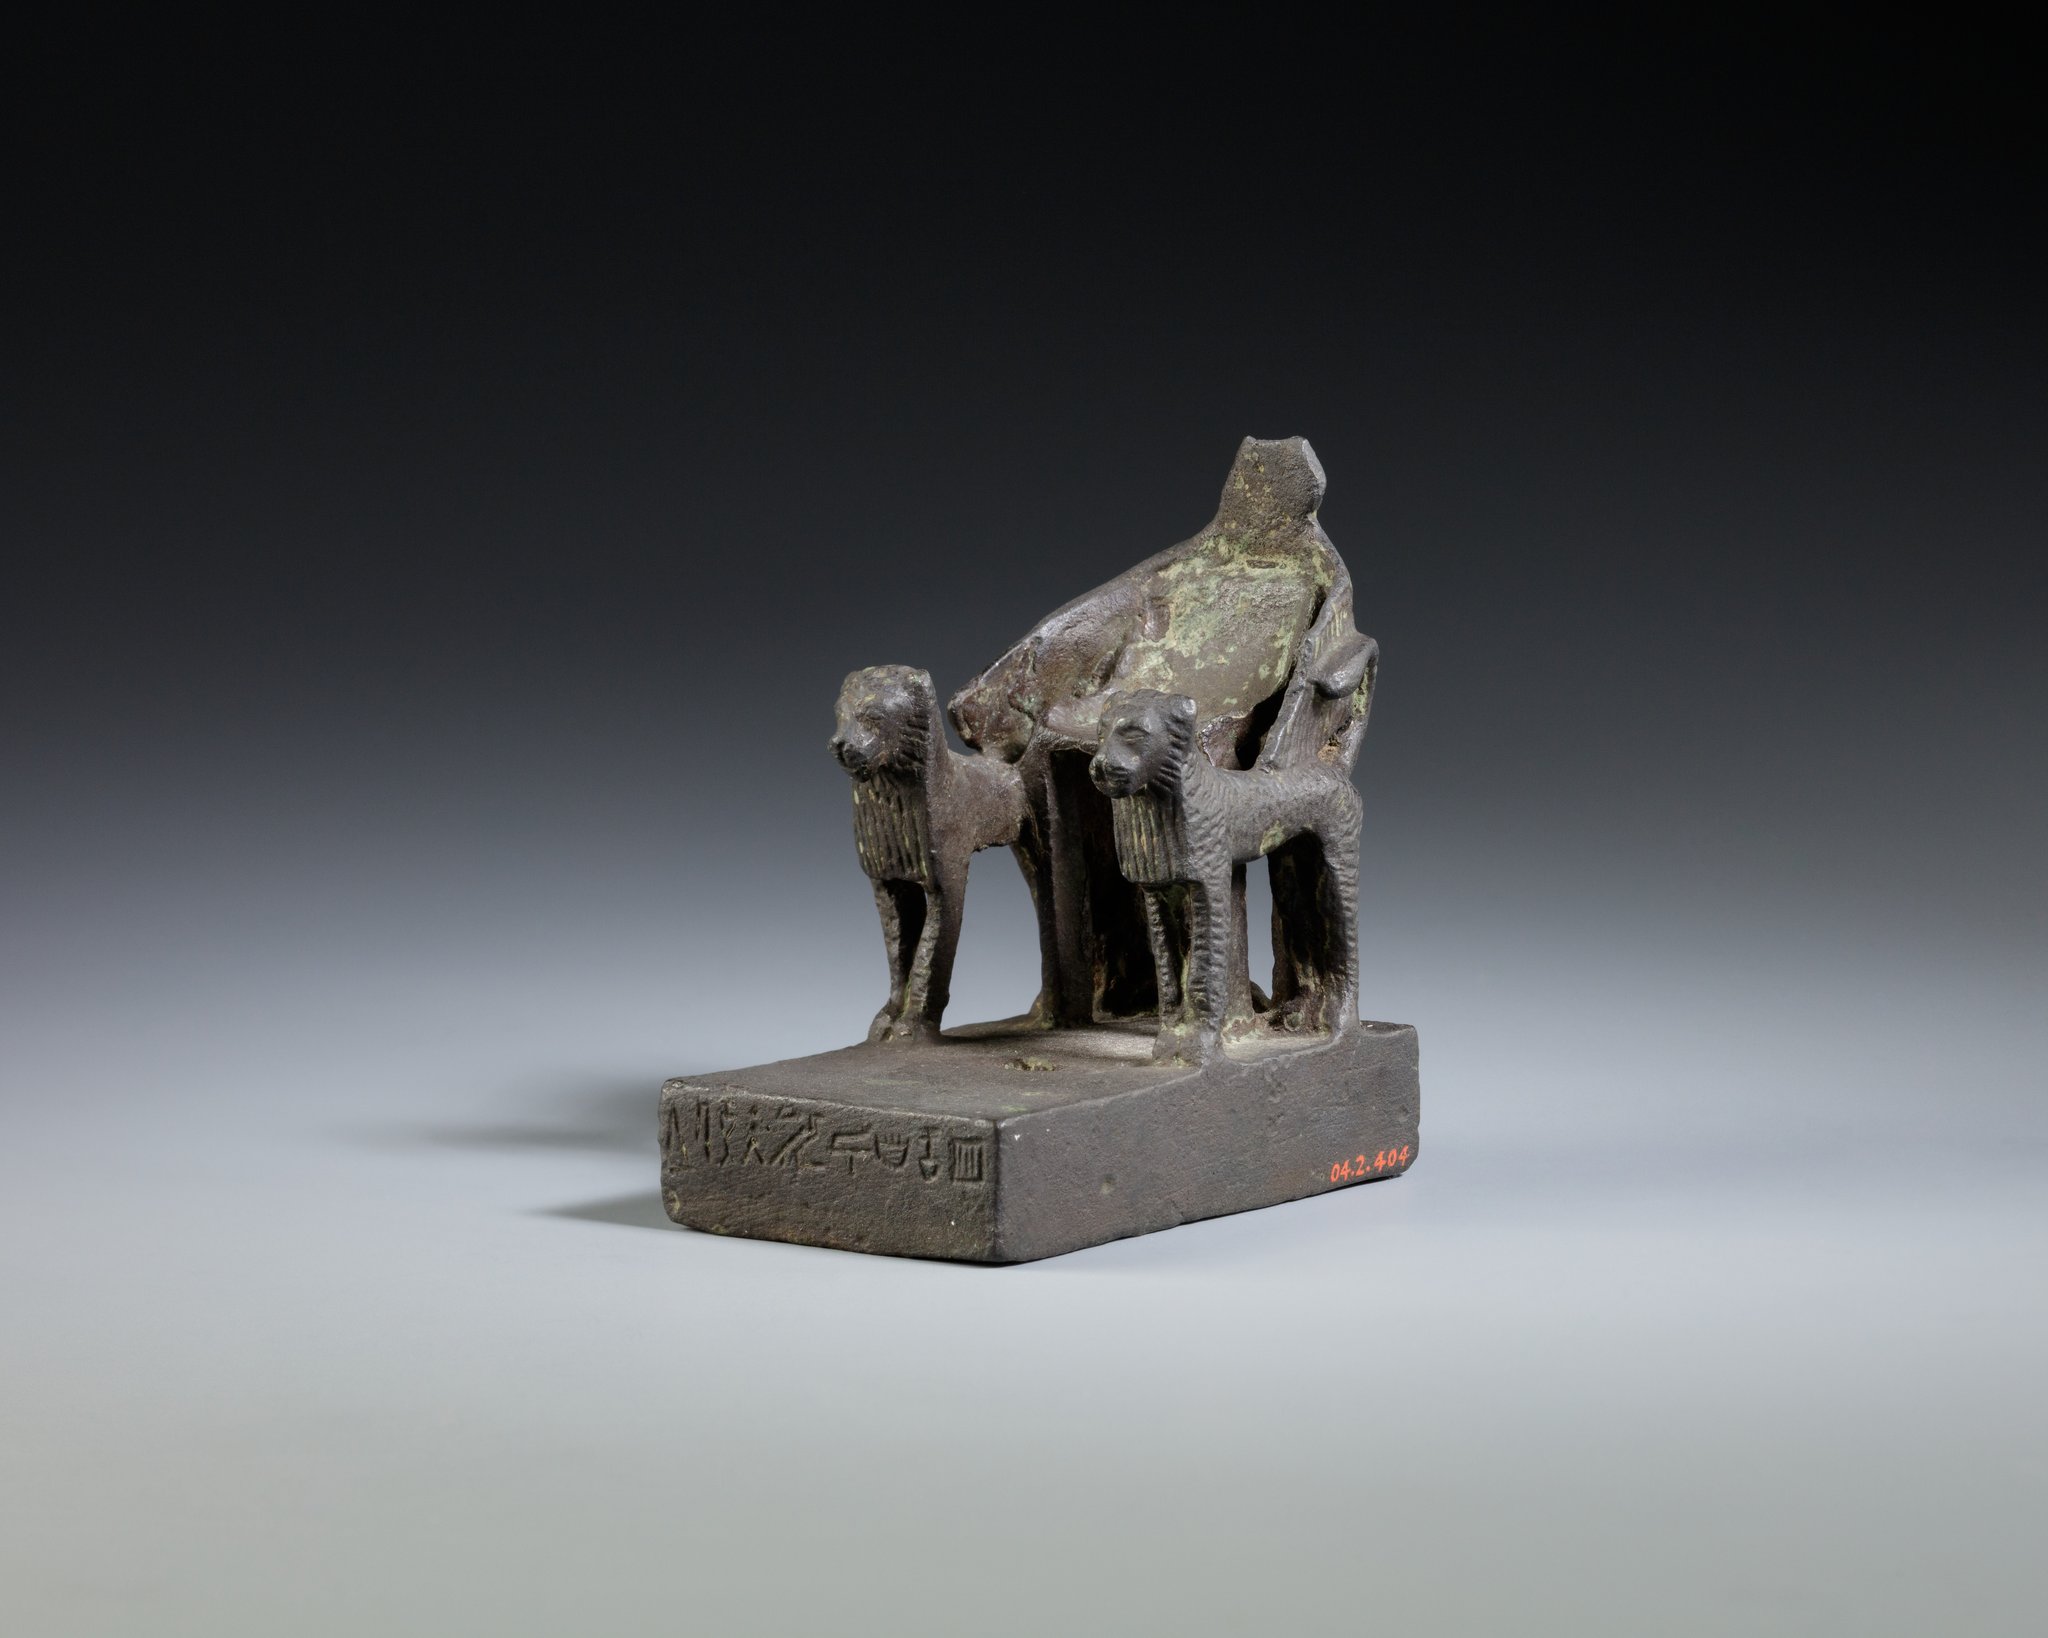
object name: statuette group, lion, armchair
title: Throne for a god with royal statue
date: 664-332 BCE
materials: bronze, copper alloy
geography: egypt